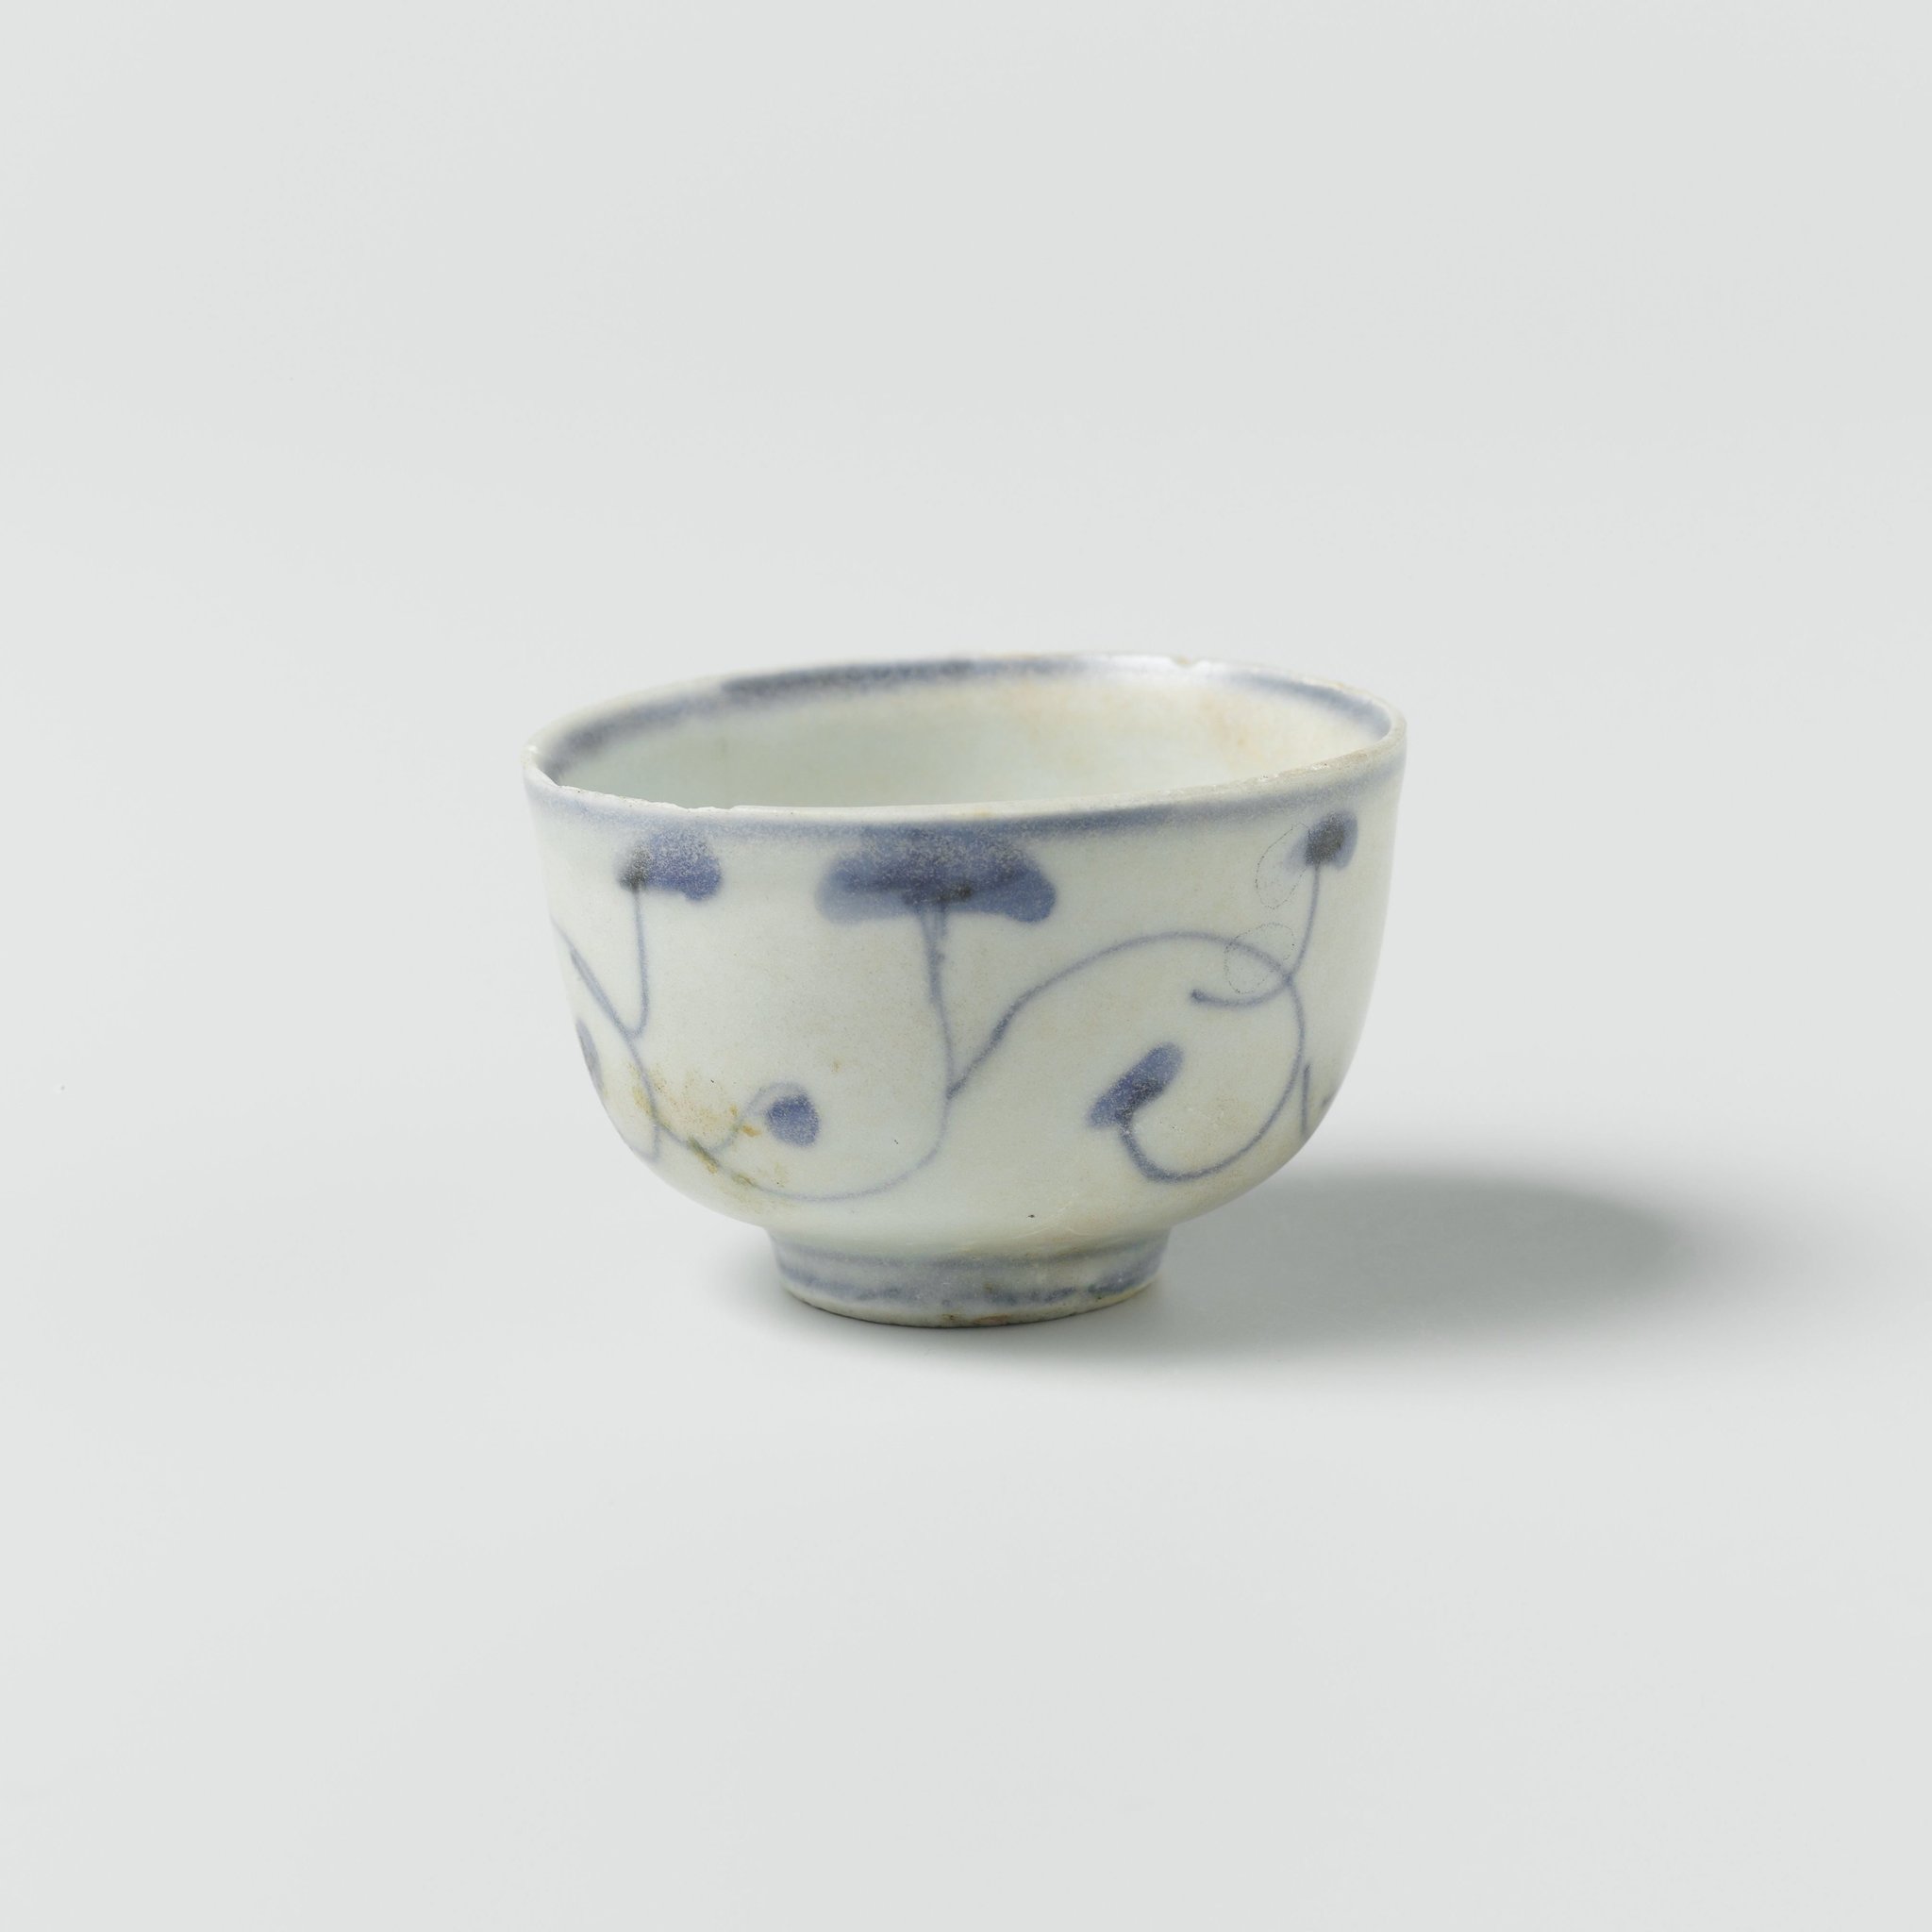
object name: bowl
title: Kom uit V.O.C.-schip de 'Witte Leeuw'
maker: Anonymous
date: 1613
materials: porcelain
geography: jingdezhen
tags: flowers ~ ornament - aa - stylized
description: A winecup. In the centre a thin line and a small blotch is drawn. On the inside a scroll of stylized flowers and stems is drawn. Around the lip-rim is a single band and around the footring a double band.